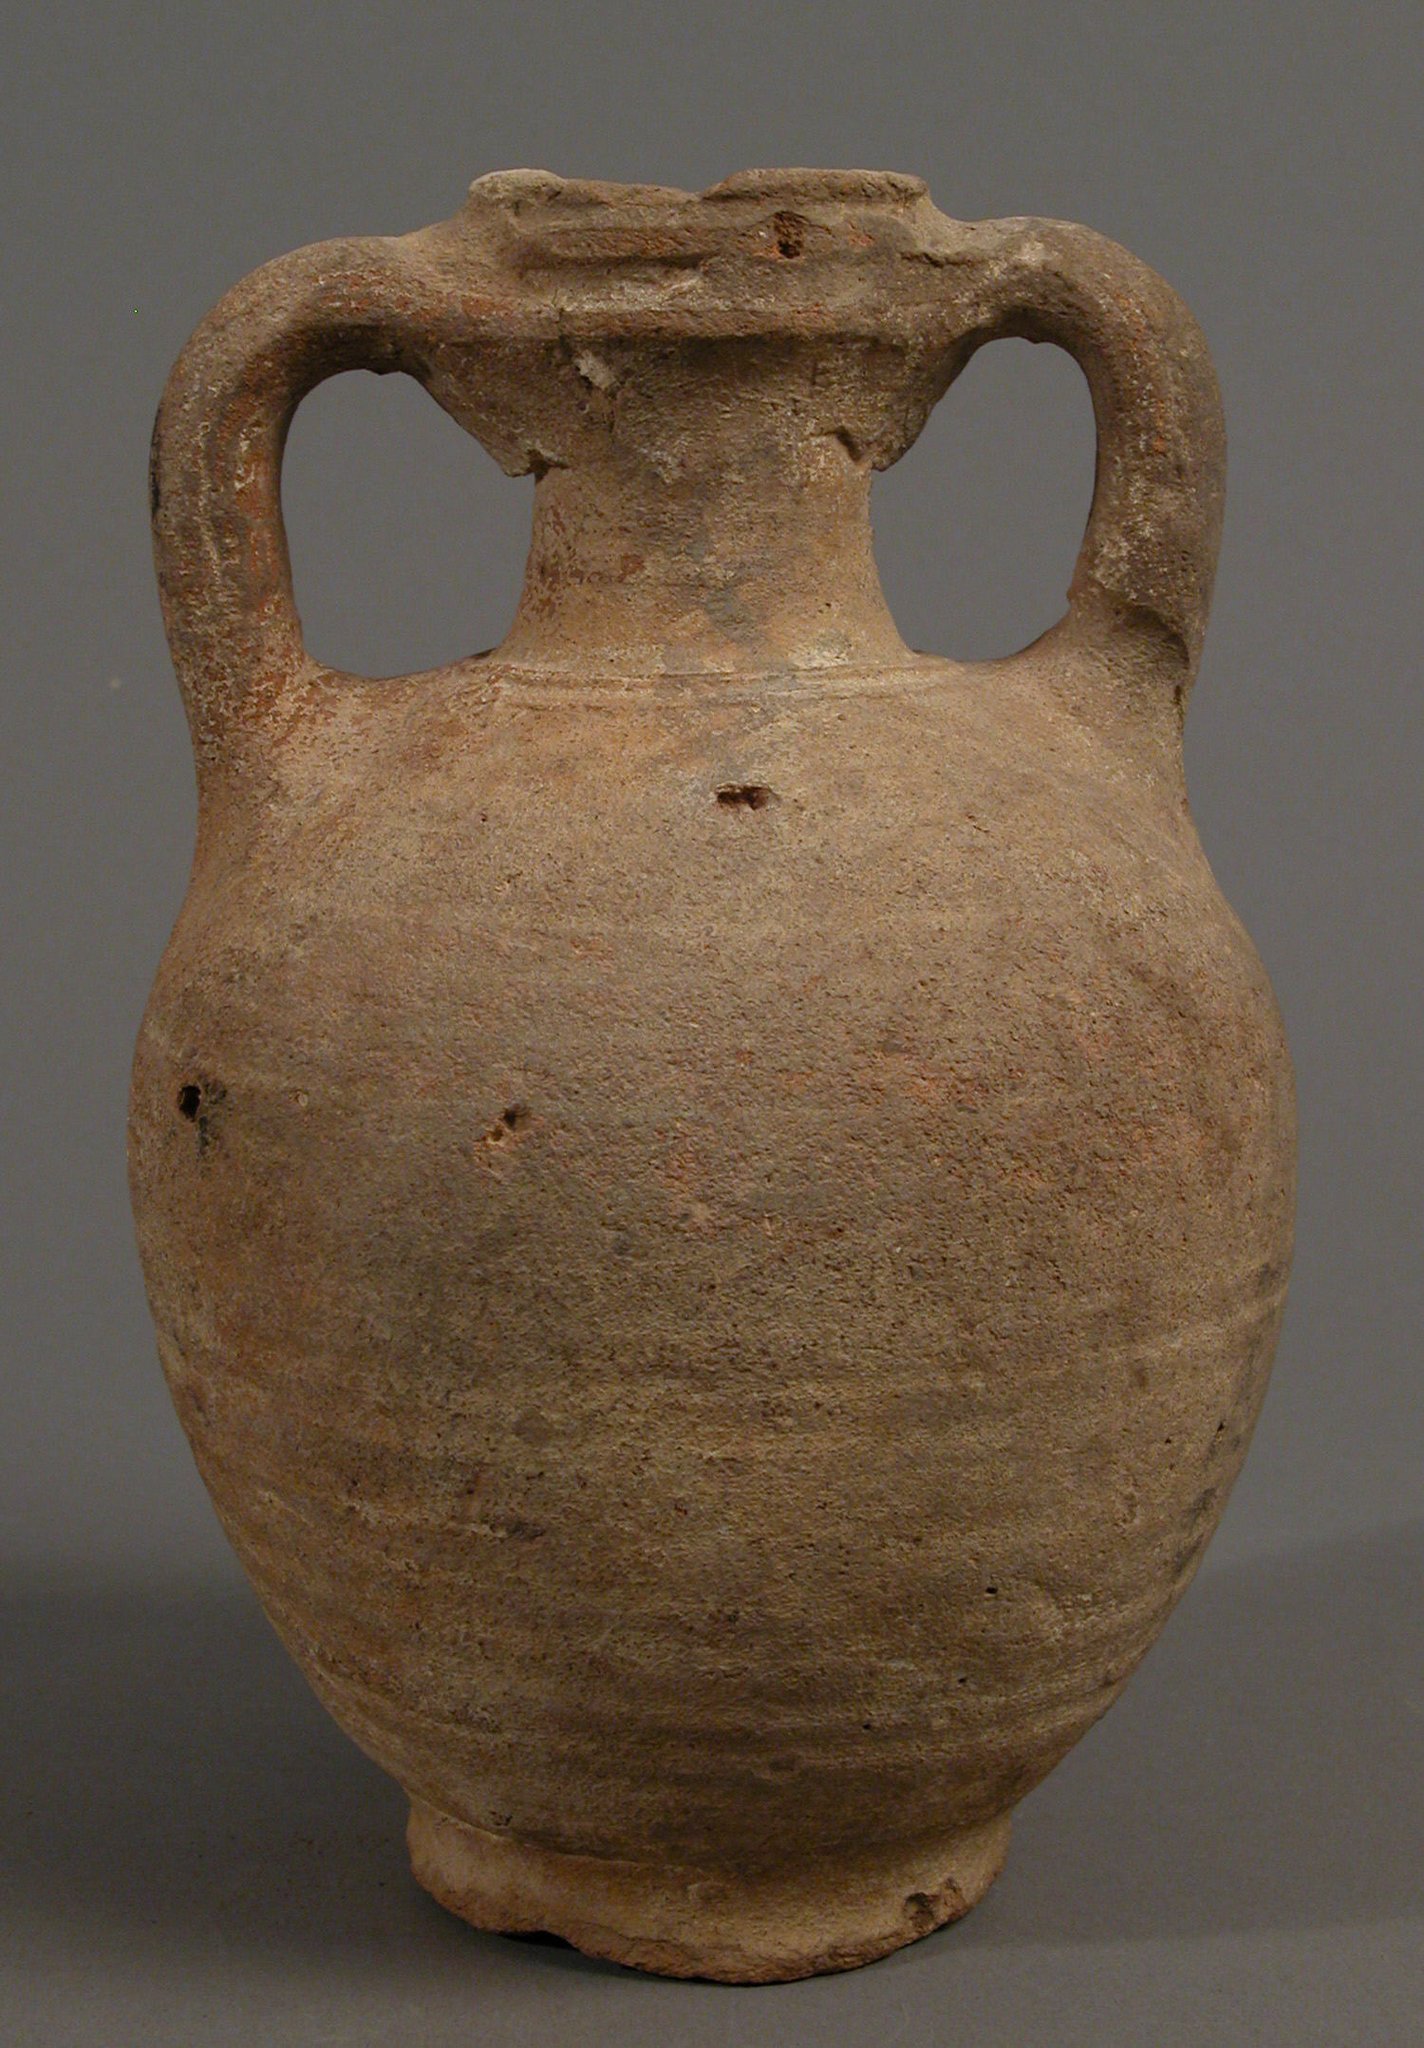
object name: pot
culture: coptic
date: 301-700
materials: earthenware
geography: egypt